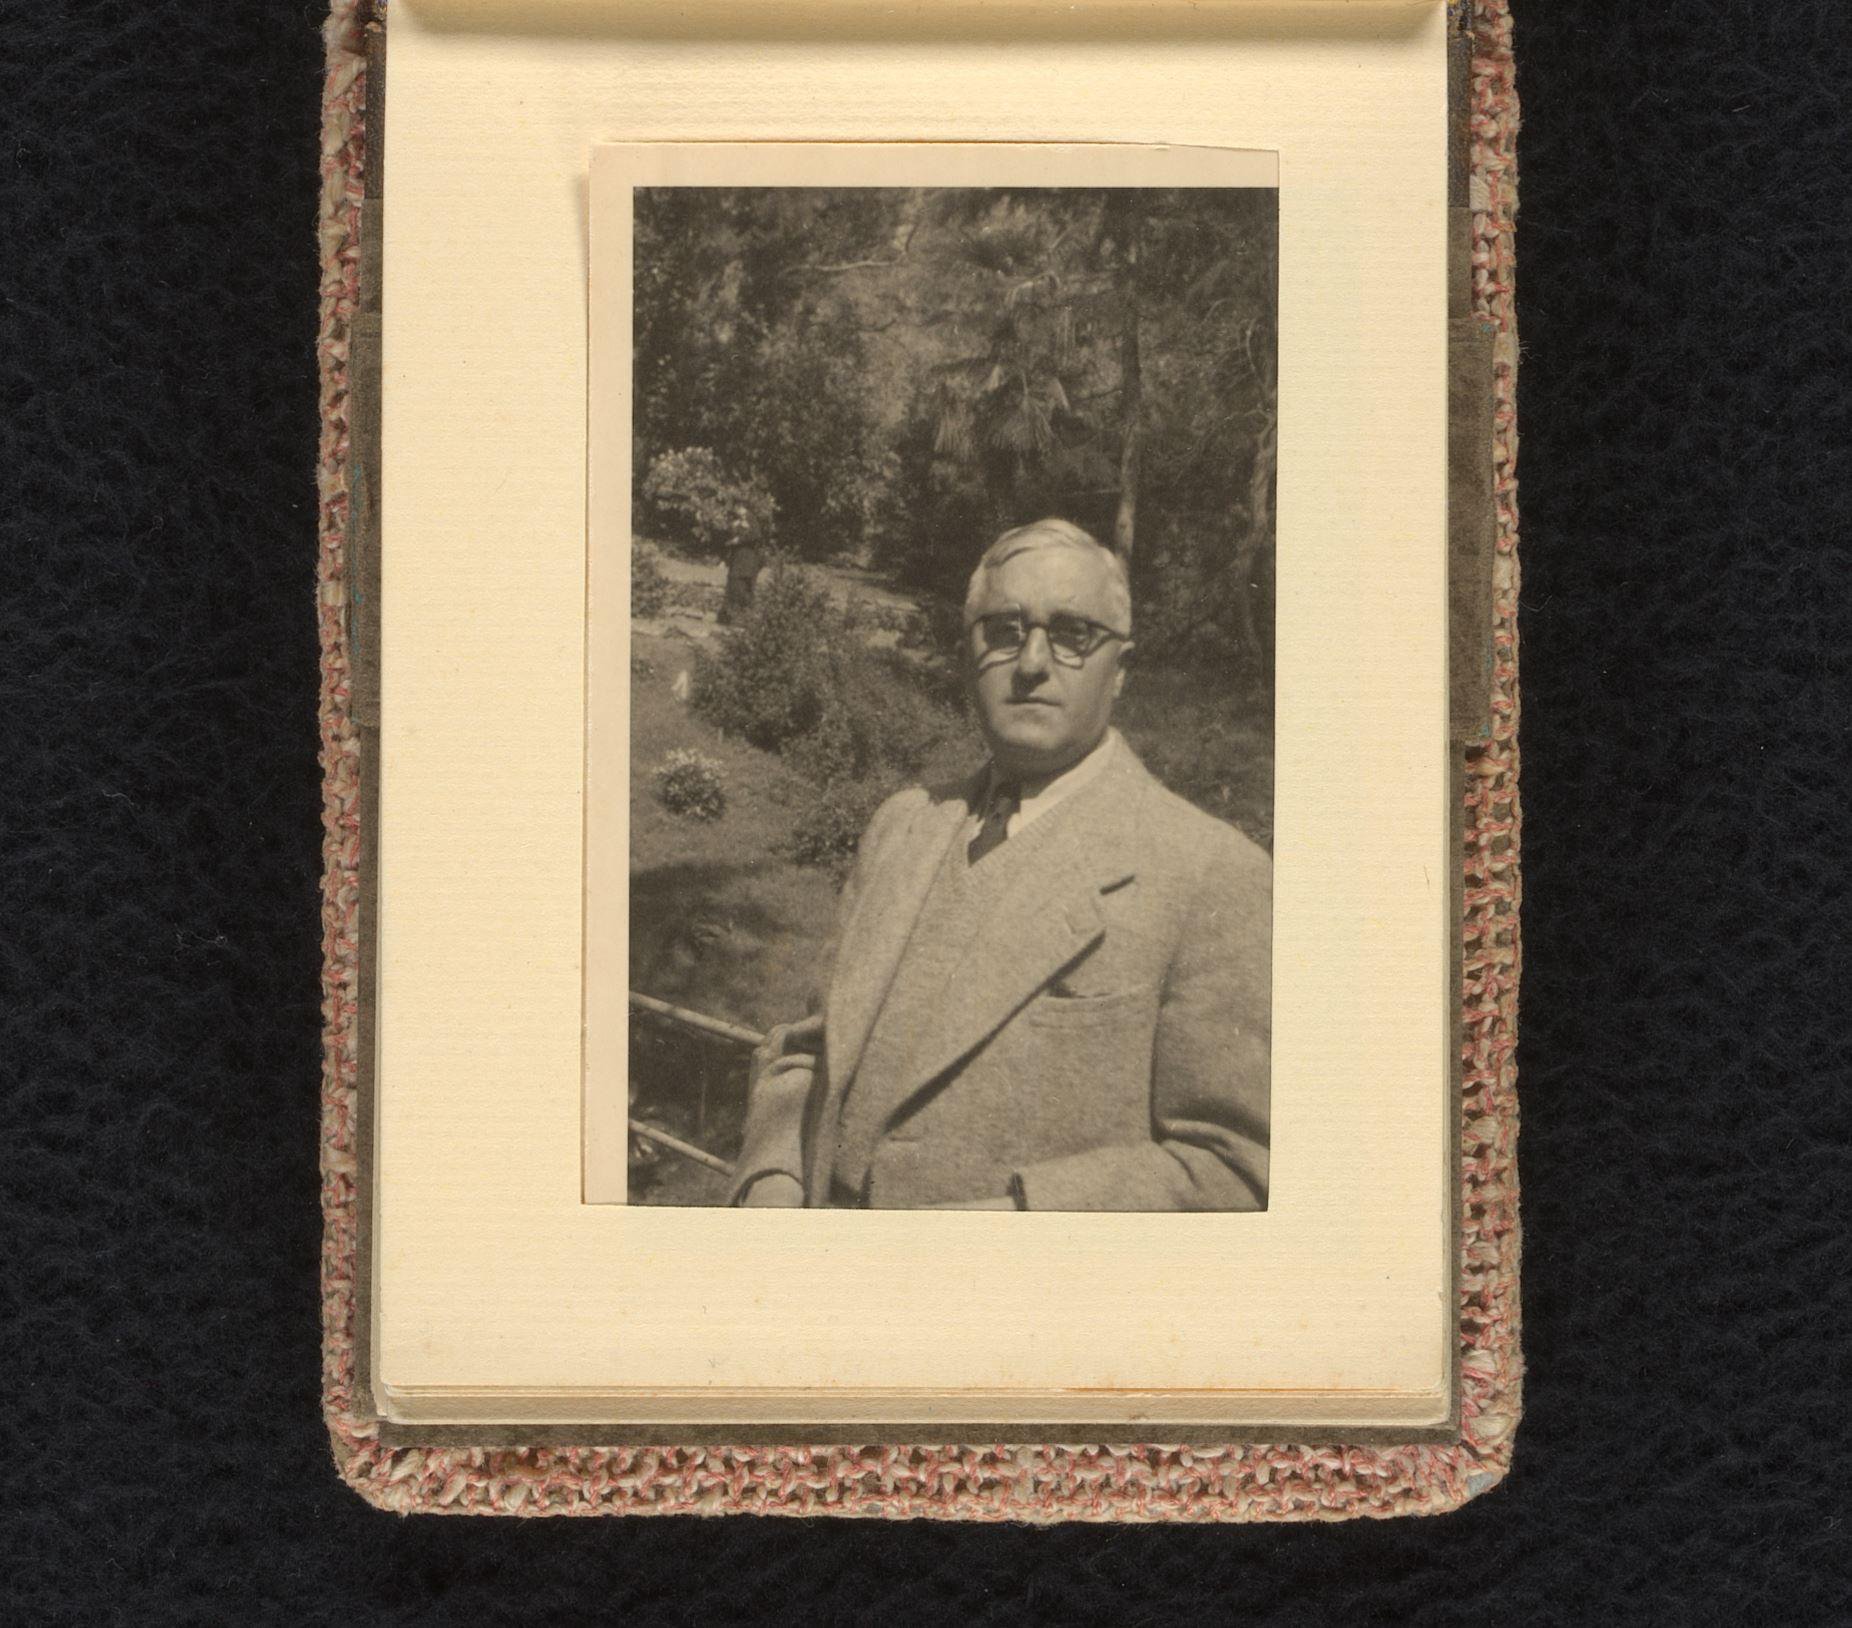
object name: photograph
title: Eugen Wachenheimer in de tuin, juli-augustus 1933, Hamburg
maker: else wachenheimer-moos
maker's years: 1895-1944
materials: paper, photographic support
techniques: gelatin silver print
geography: hamburg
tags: eugen wachenheimer, the family travelling, on holiday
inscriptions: date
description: Albumblad bevat een foto van Eugen Wachenheimer. Onderdeel van het fotoalbum Hamburg zomer 1933.